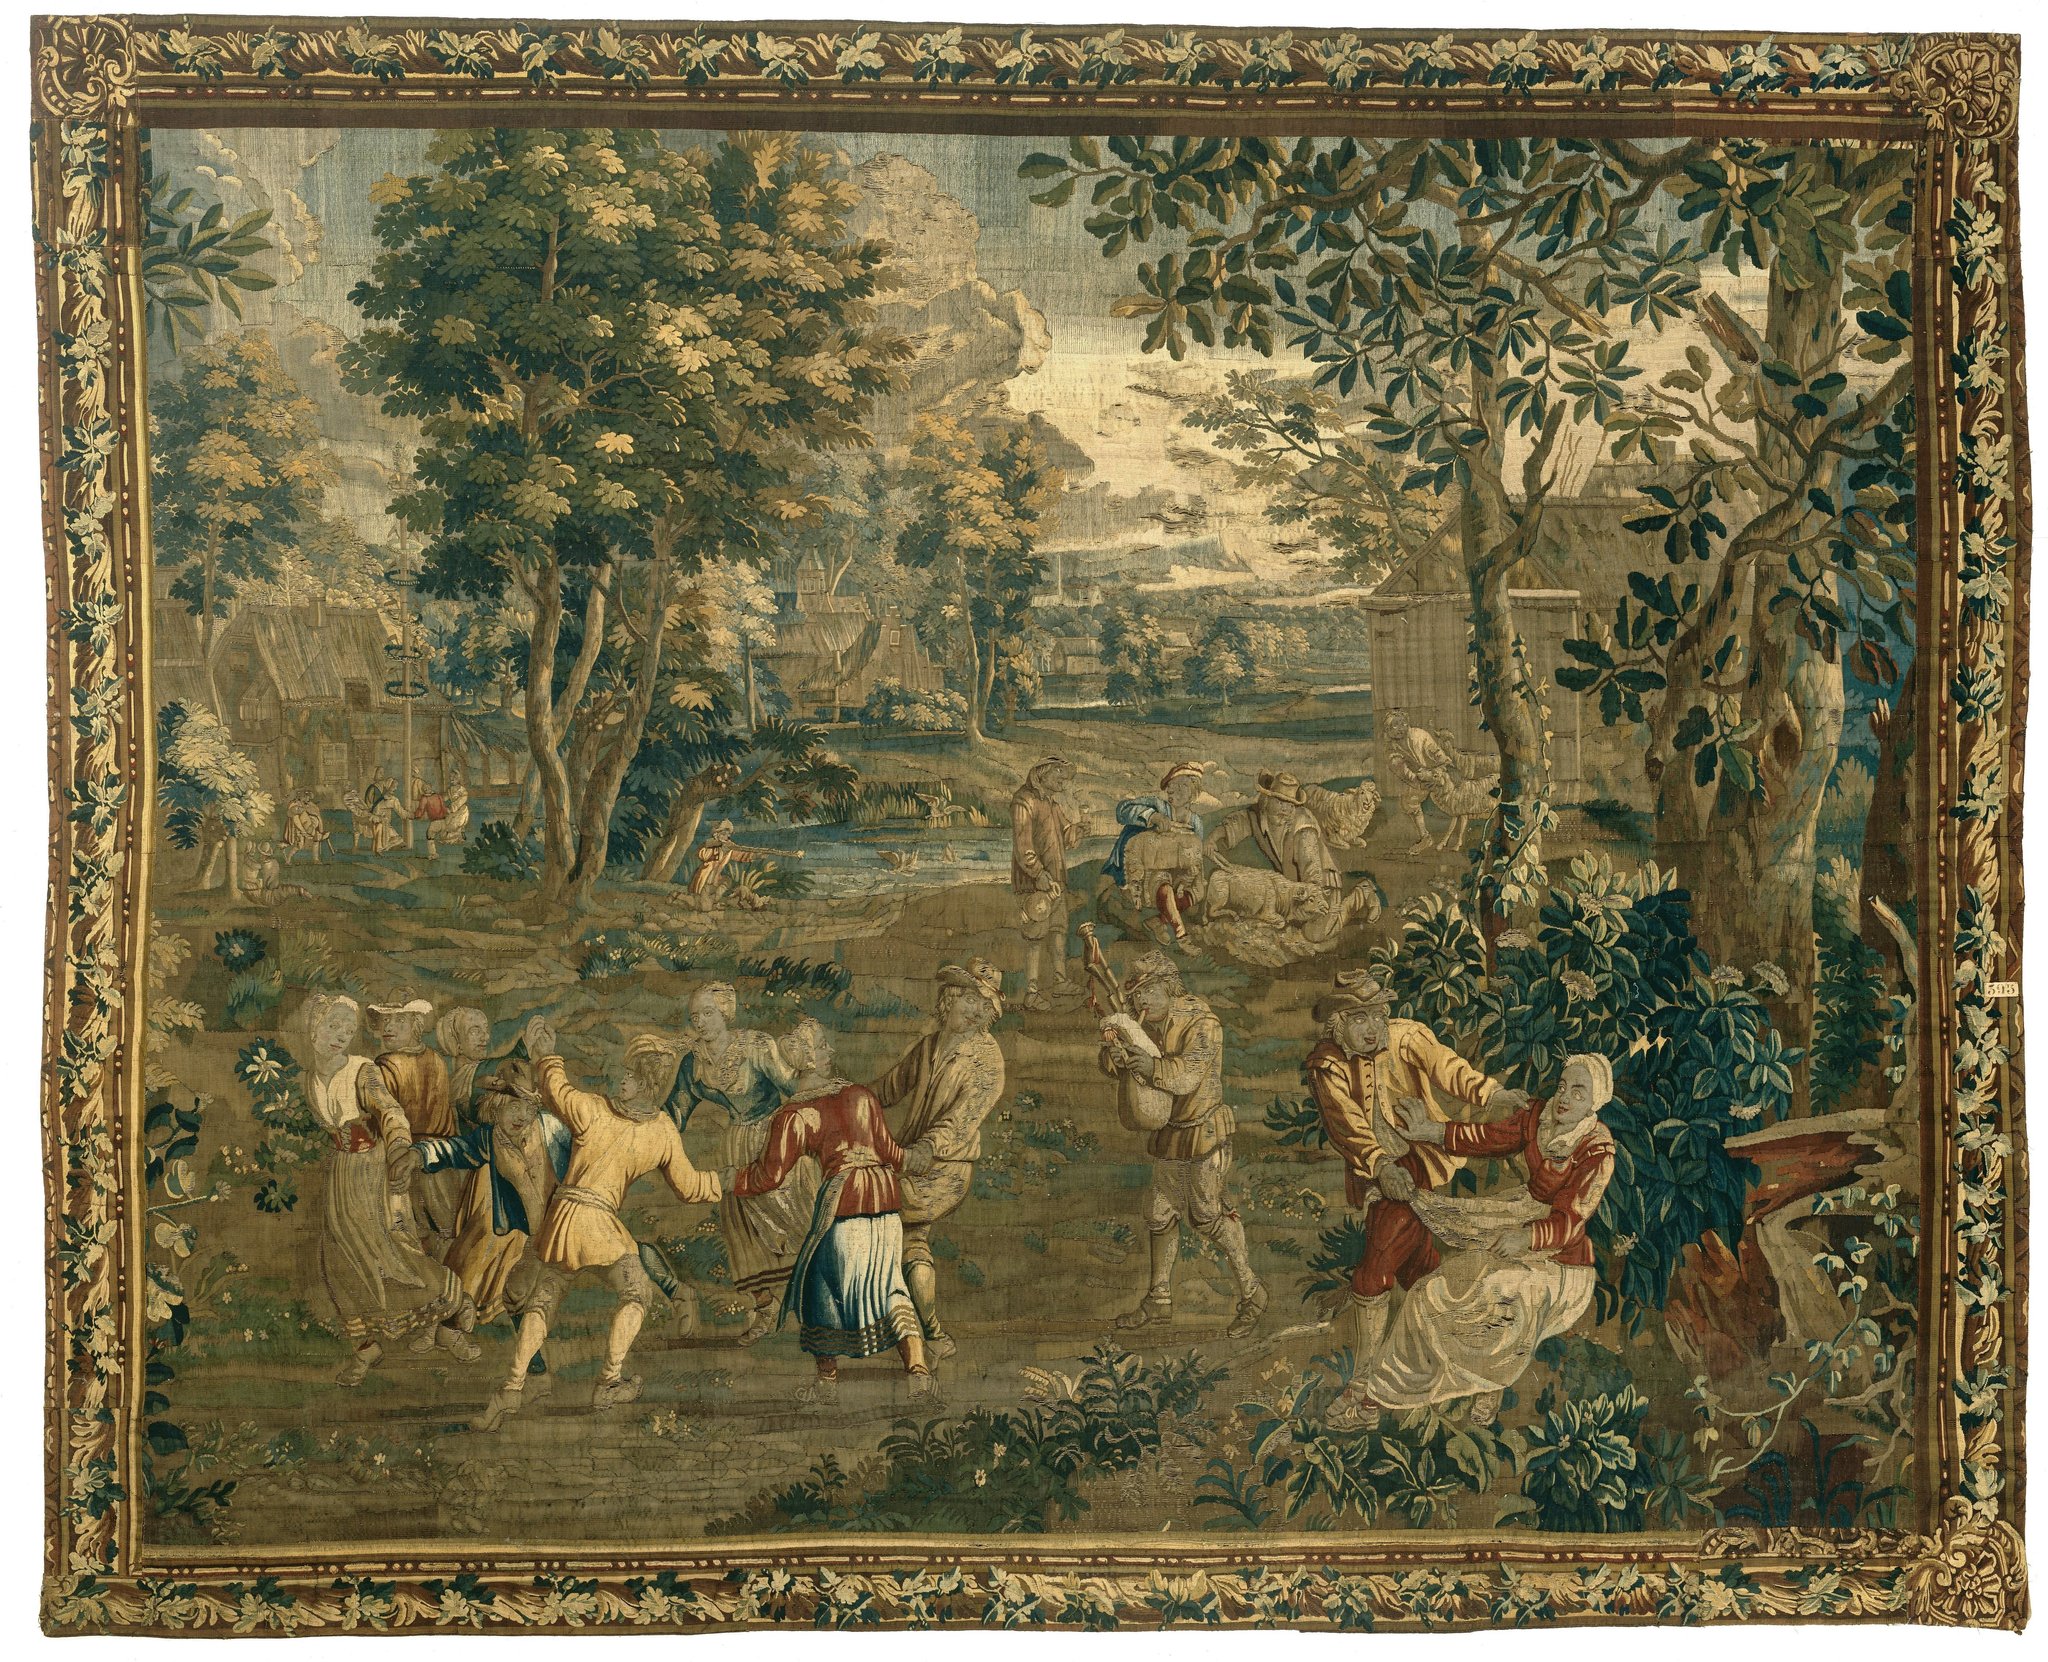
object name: tapestry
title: Het volksleven naar Teniers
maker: Anonymous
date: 1700-1725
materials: silk, wool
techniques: tapestry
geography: southern netherlands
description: Wandtapijt met dansende boeren, schaapscheerders en dans rond de meiboom.